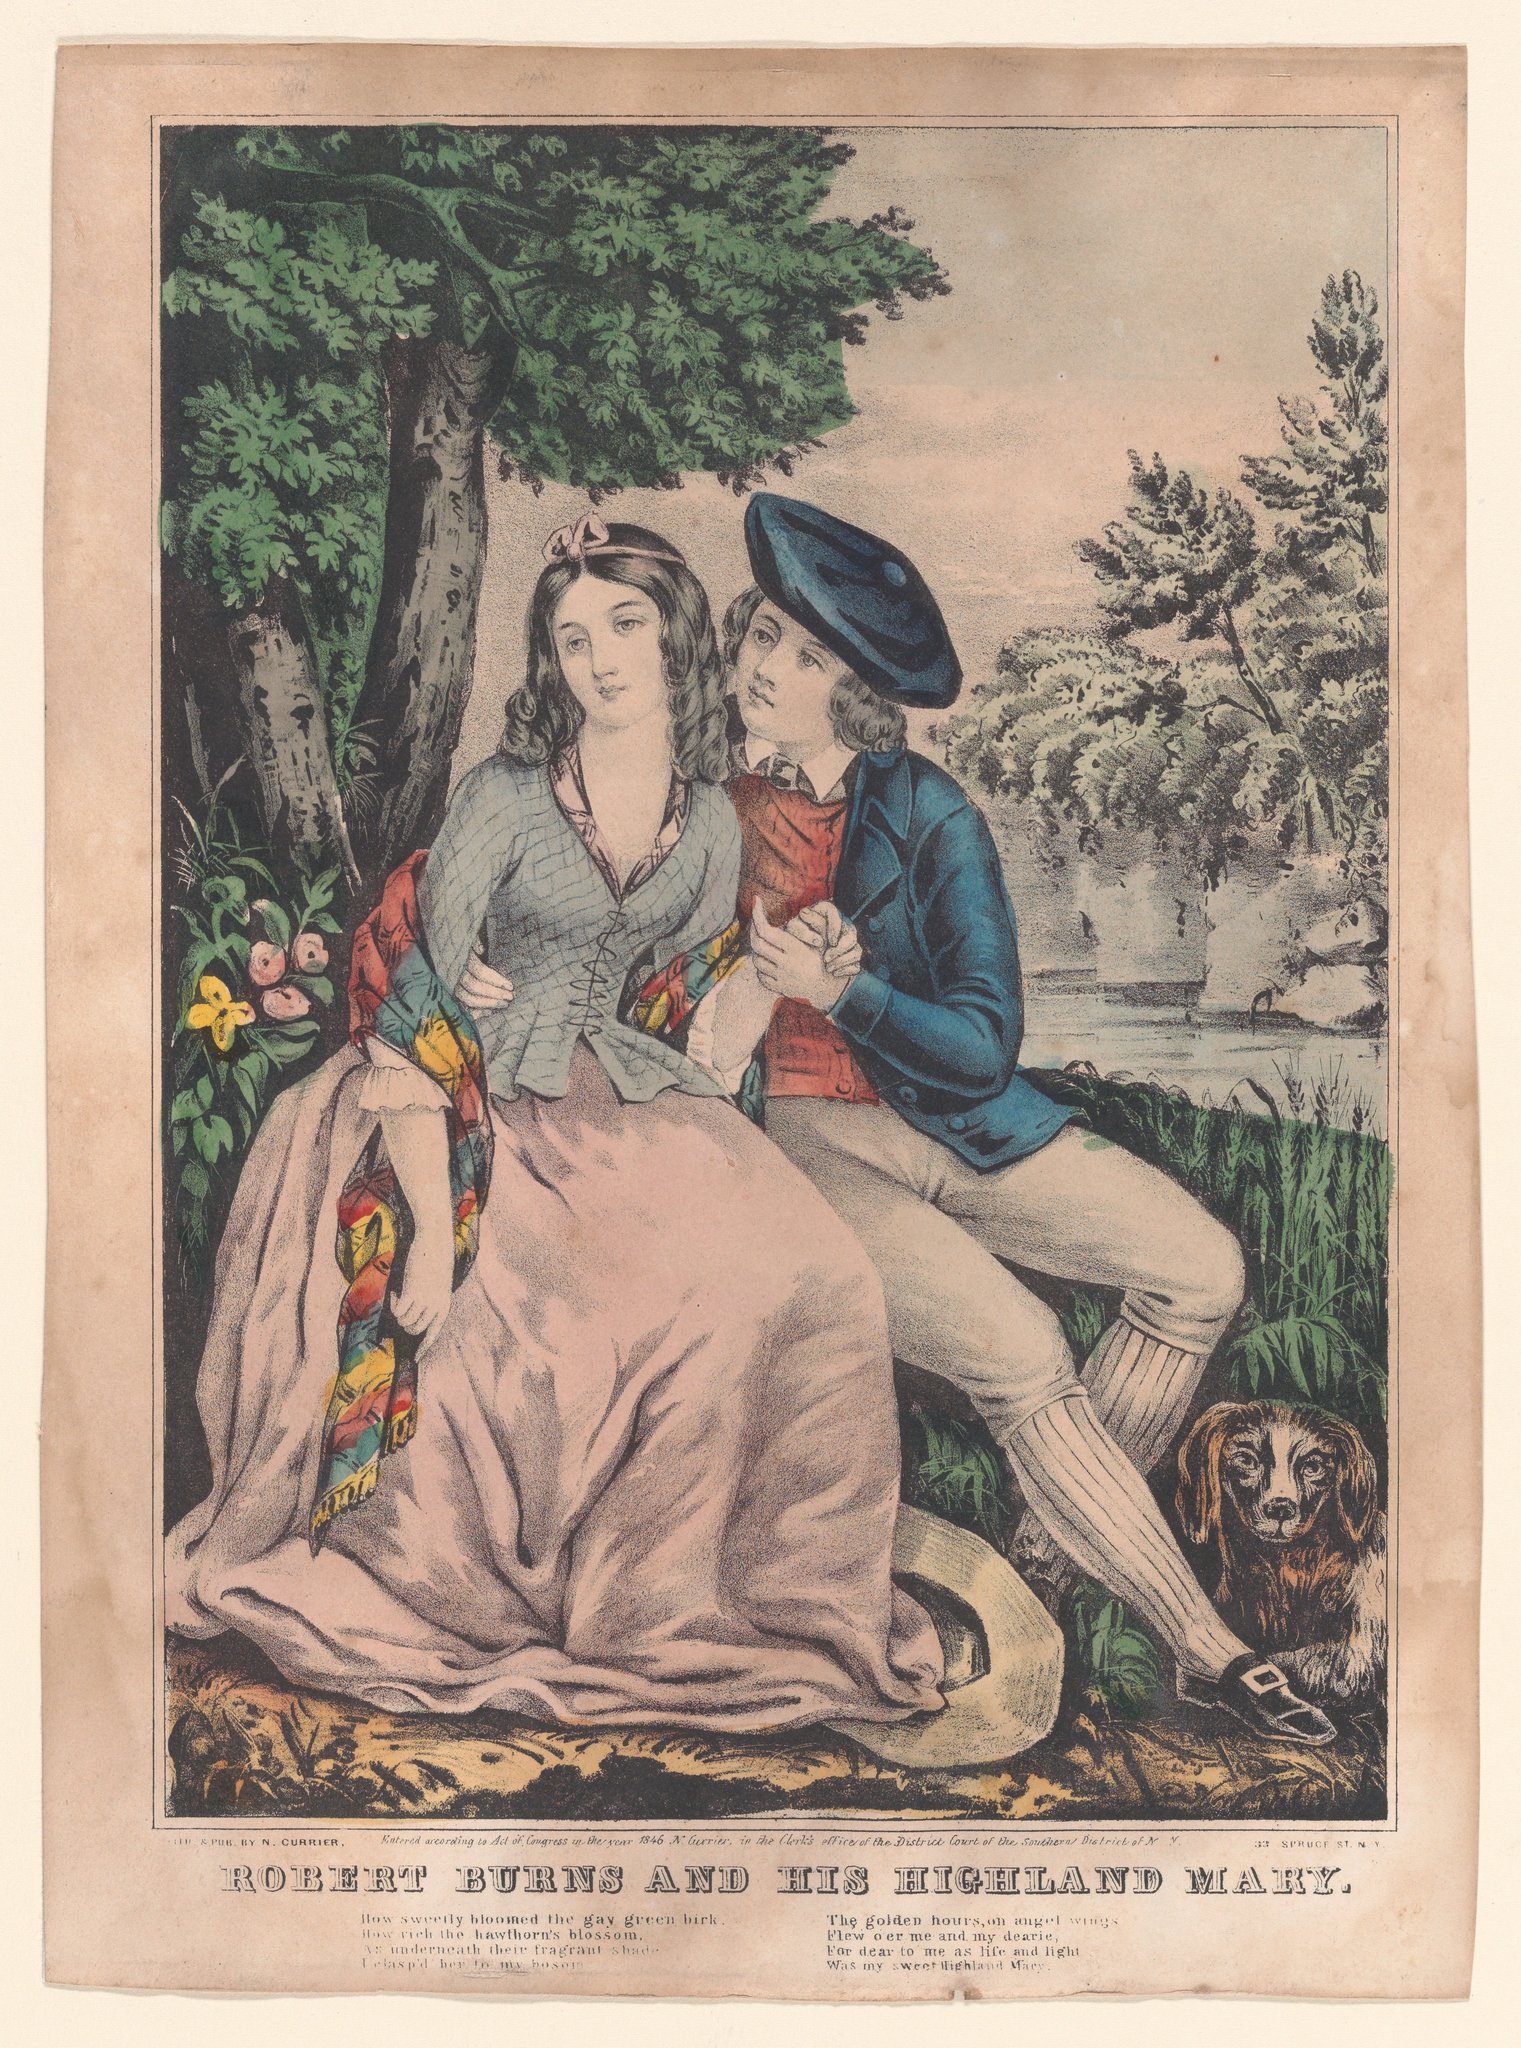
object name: print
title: Robert Burns and His Highland Mary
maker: nathaniel currier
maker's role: publisher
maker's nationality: american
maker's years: 1813-1888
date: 1846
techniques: hand coloring, lithograph